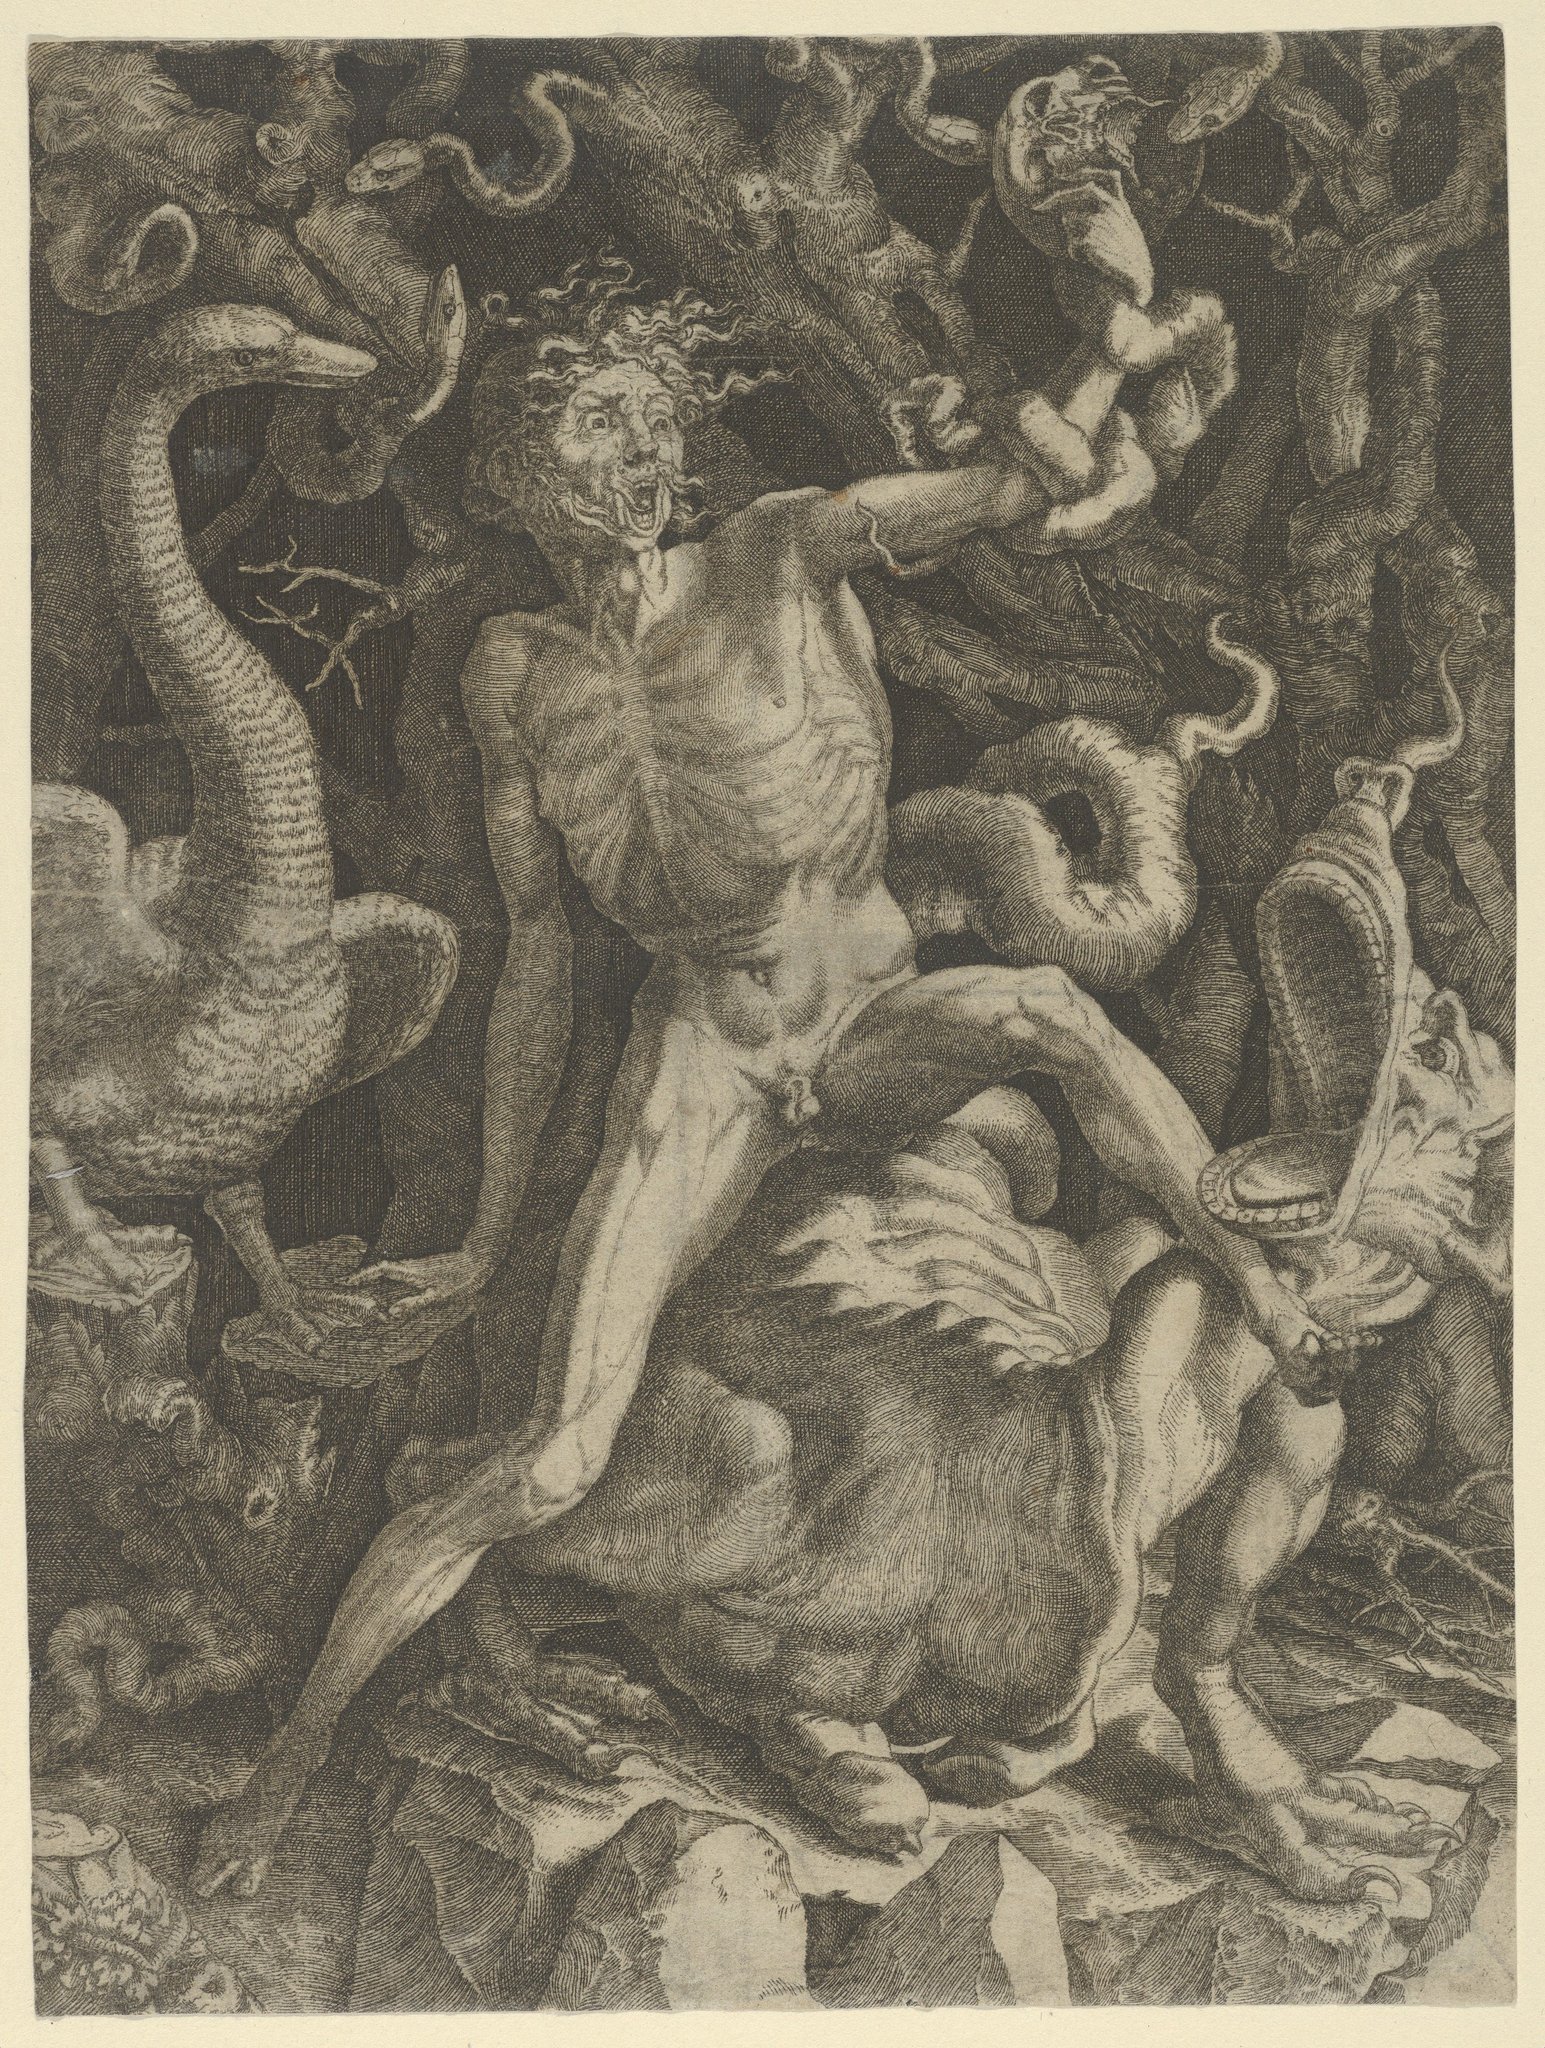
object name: print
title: Fury personified as an emaciated man astride a monster, holding a skull in his raised left hand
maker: giovanni jacopo caraglio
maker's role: artist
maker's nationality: italian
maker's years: 1500-1565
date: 1520-1539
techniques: engraving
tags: male nudes,monsters